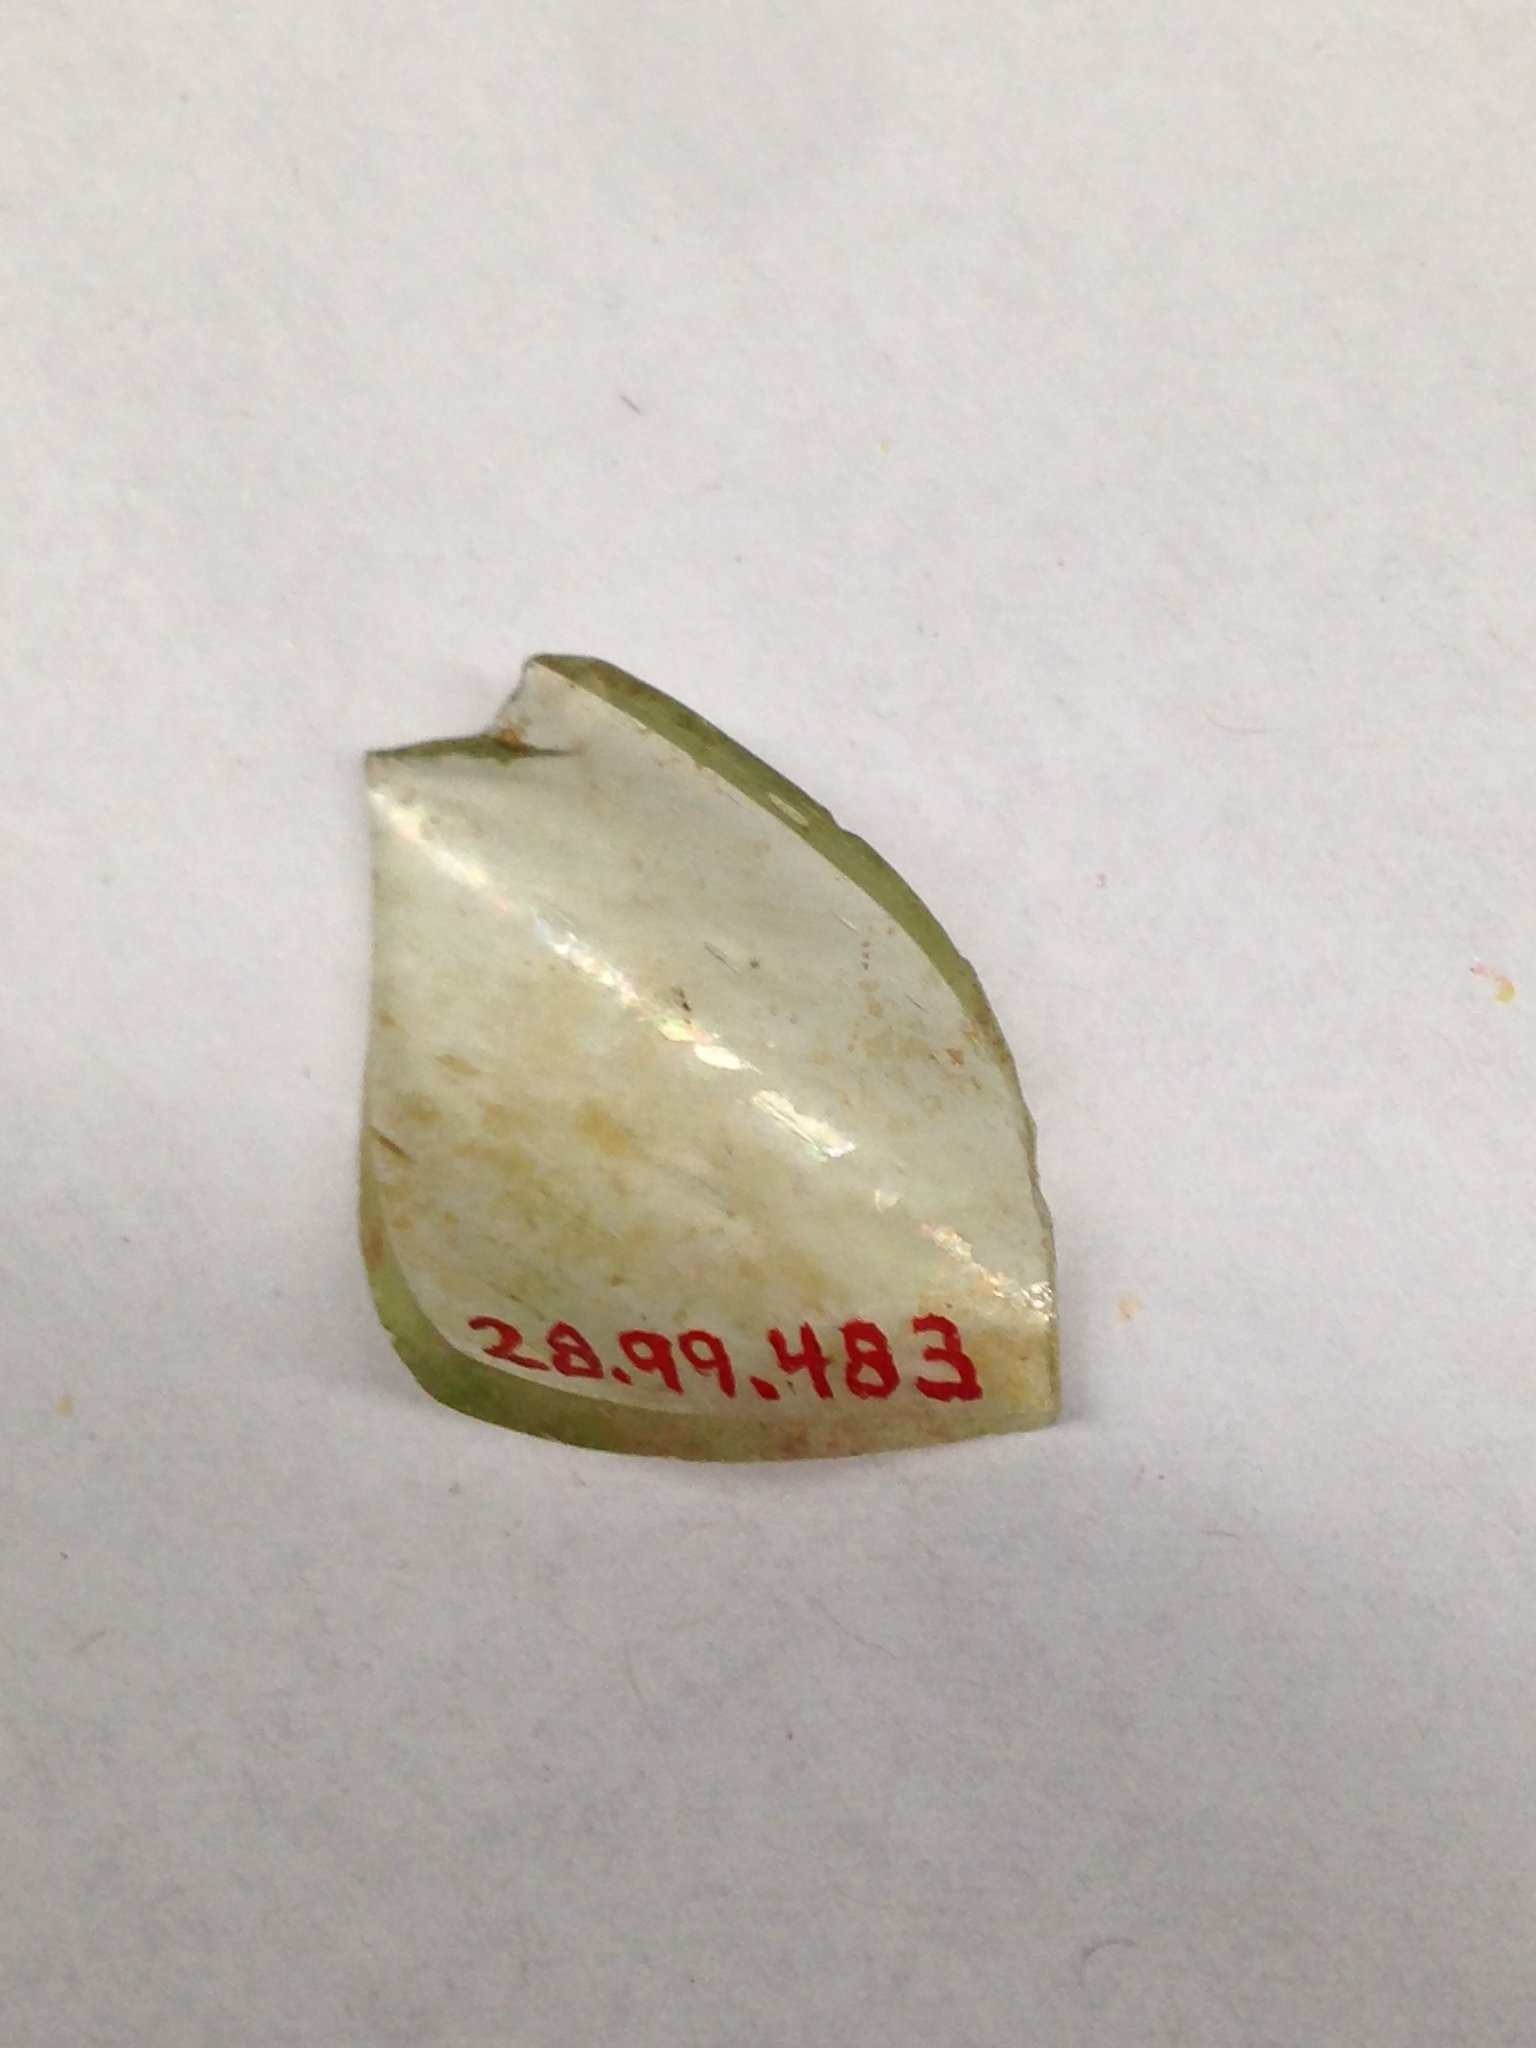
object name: fragment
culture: european or middle eastern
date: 1150-1250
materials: ceramic, glass